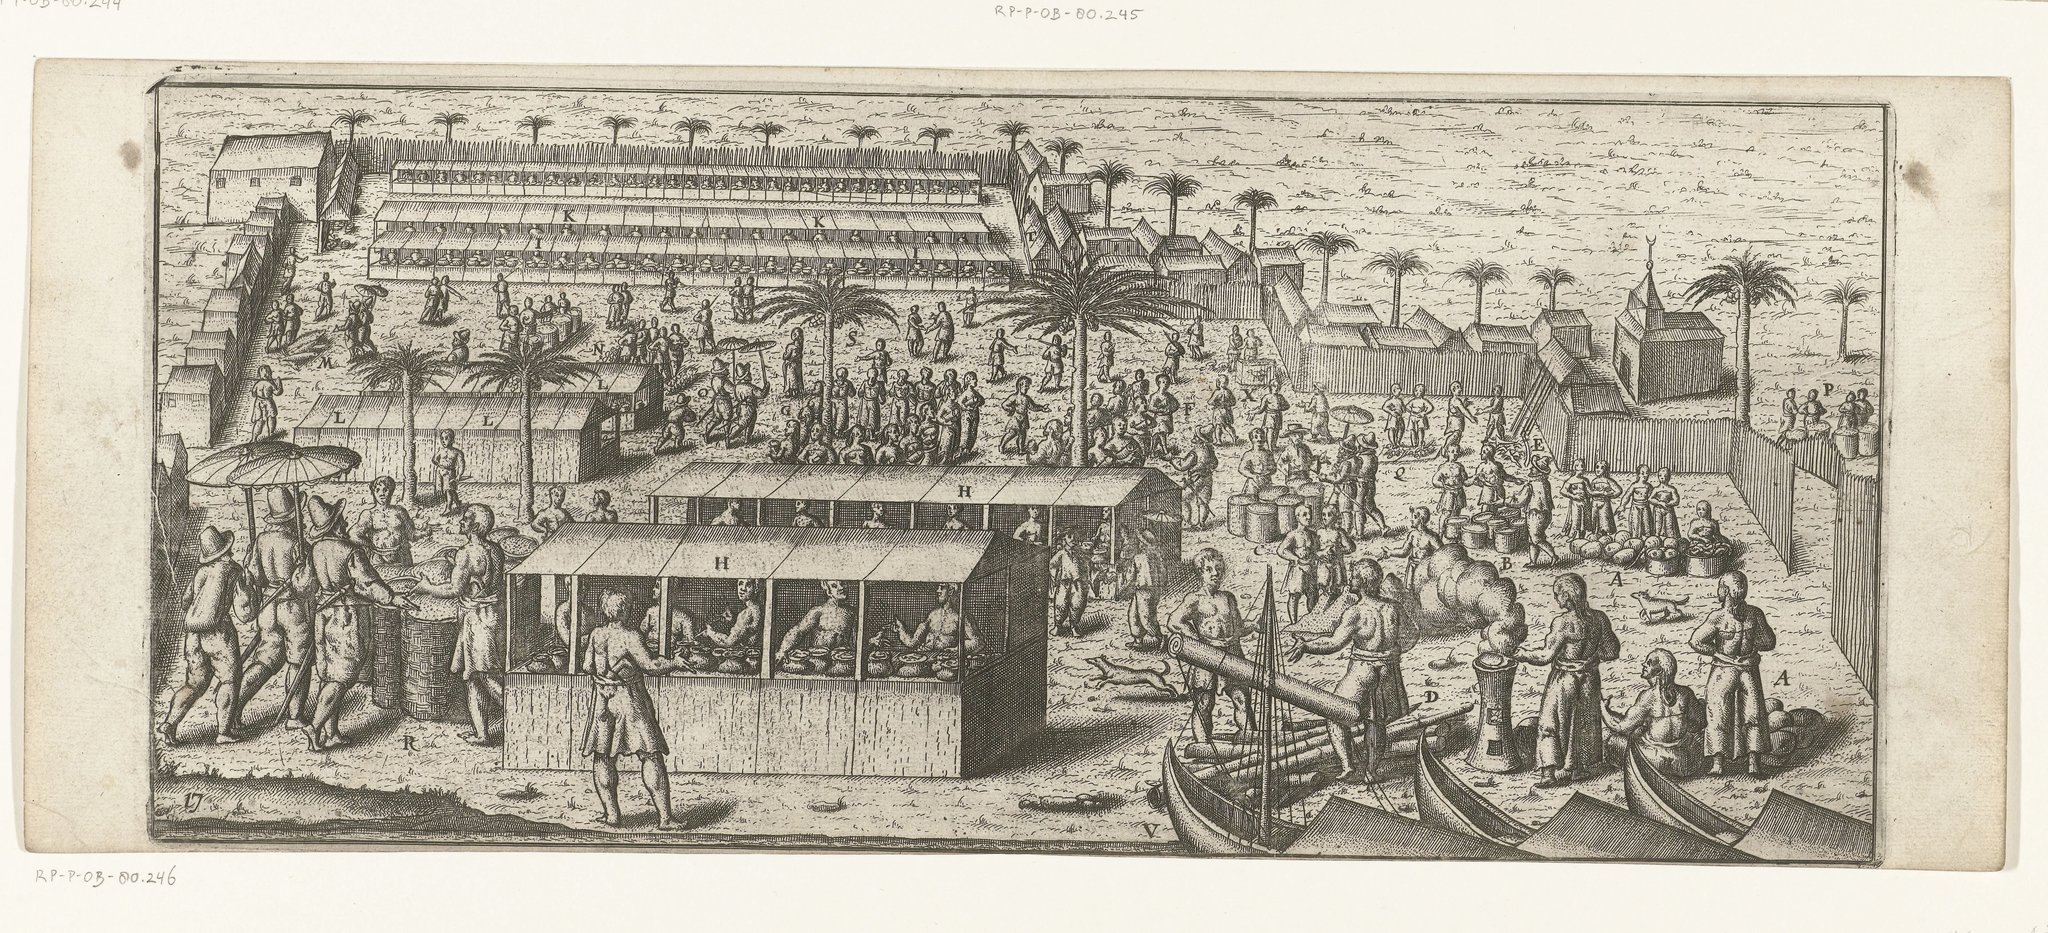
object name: print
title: Bazaar van Bantam, 1596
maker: Anonymous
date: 1597-1598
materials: paper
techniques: engraving, etching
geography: northern netherlands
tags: gouda, landscapes in tropical and sub-tropical regions, exploration, expedition, voyage of discovery, market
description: Gebruikt als illustratie eerst in: Willem Lodewijcksz, D'eerste boeck. Historie van Indien, waer inne verhaelt is de avontueren die de Hollandtsche schepen bejeghent zijn, Cornelis Claes, Amsterdam 1598. In deze opgewerkte staat gebruikt in: De Eerste Schipvaerd der Hollandsche Natie naer Oost-Indien, waer inne verhaelt wordt al wat haer sonderlings onder wegen bejegent is ... ghetrocken uyt verscheyden Iournalen ofte dagh-registers daer van ghemaeckt, zeer vermaeckelijck ende nut om lesen. Opgenomen in: I. Commelin, Begin ende voortgangh, van de Vereenighde Nederlantsche Geoctroyeerde Oost-Indische Compagnie, J. Janssonius, Amsterdam 1646. Genummerd: 17.